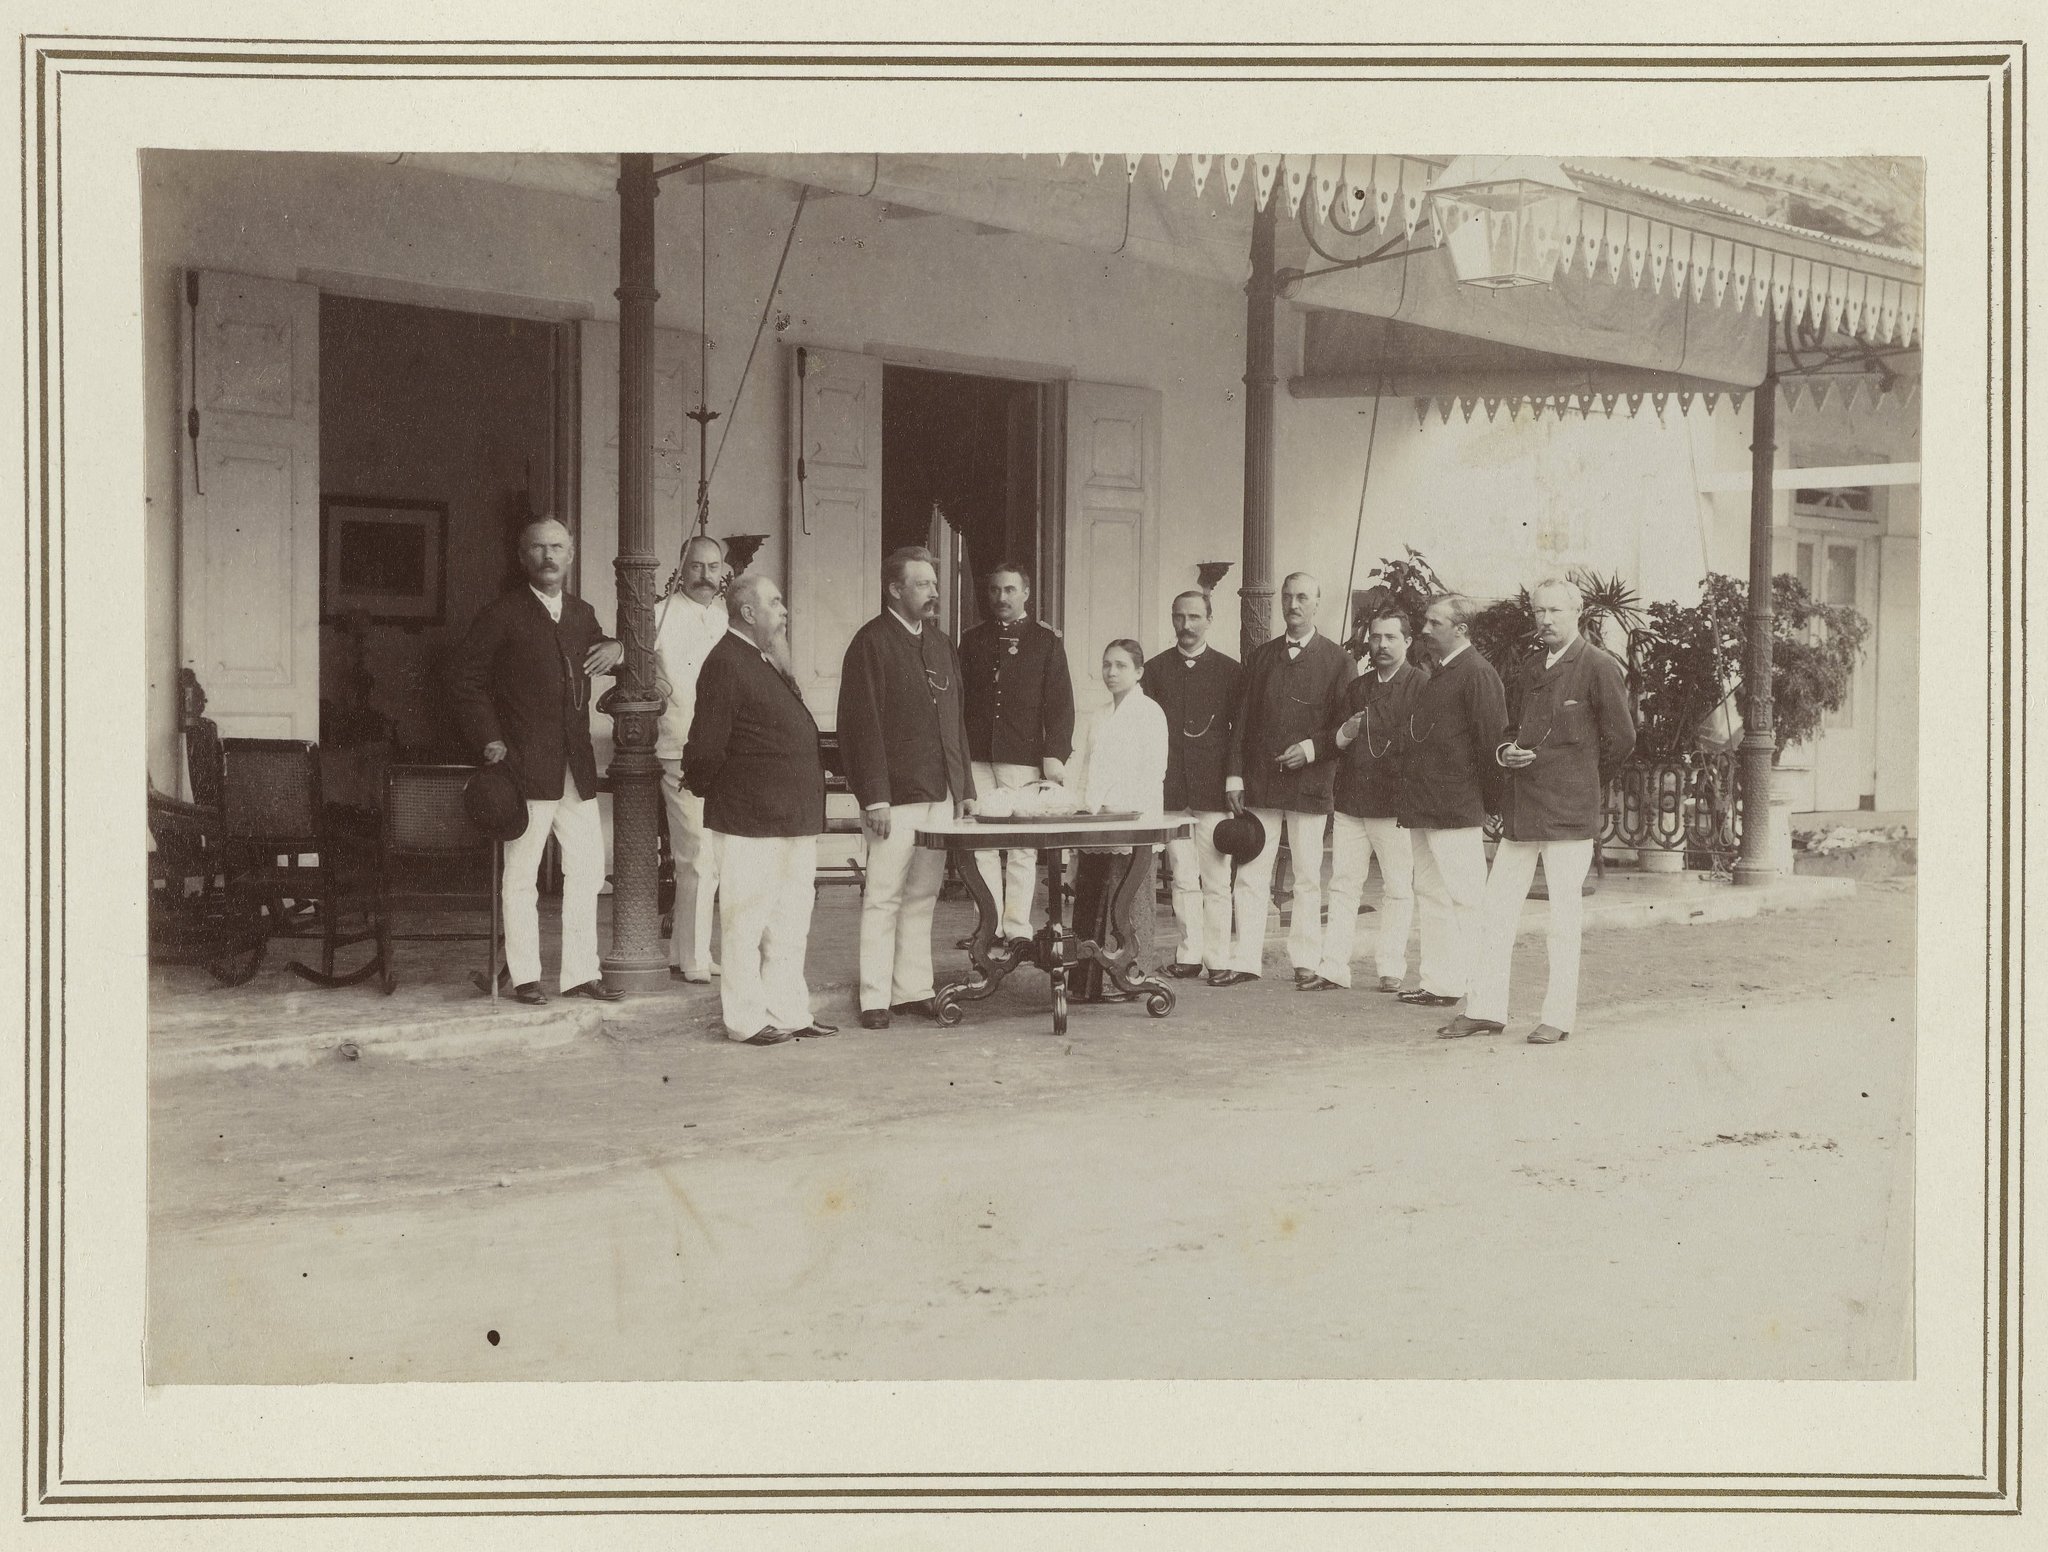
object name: photograph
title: Groepsfoto voor een huis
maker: kassian céphas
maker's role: fotograaf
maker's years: 1845-1912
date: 1886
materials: photographic support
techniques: albumen print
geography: jogjakarta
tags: the hague, anonymous historical persons portrayed in a group, in a group-portrait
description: Groepsfoto van een groep staande mannen rond een tafeltje met een Indonesische vrouw, op straat voor een huis, waarschijnlijk in of bij Jogyakarta. Onderdeel van het fotoalbum aangeboden aan J.M. Pijnacker Hordijk bij zijn vertrek uit Jogyakarta in 1886.